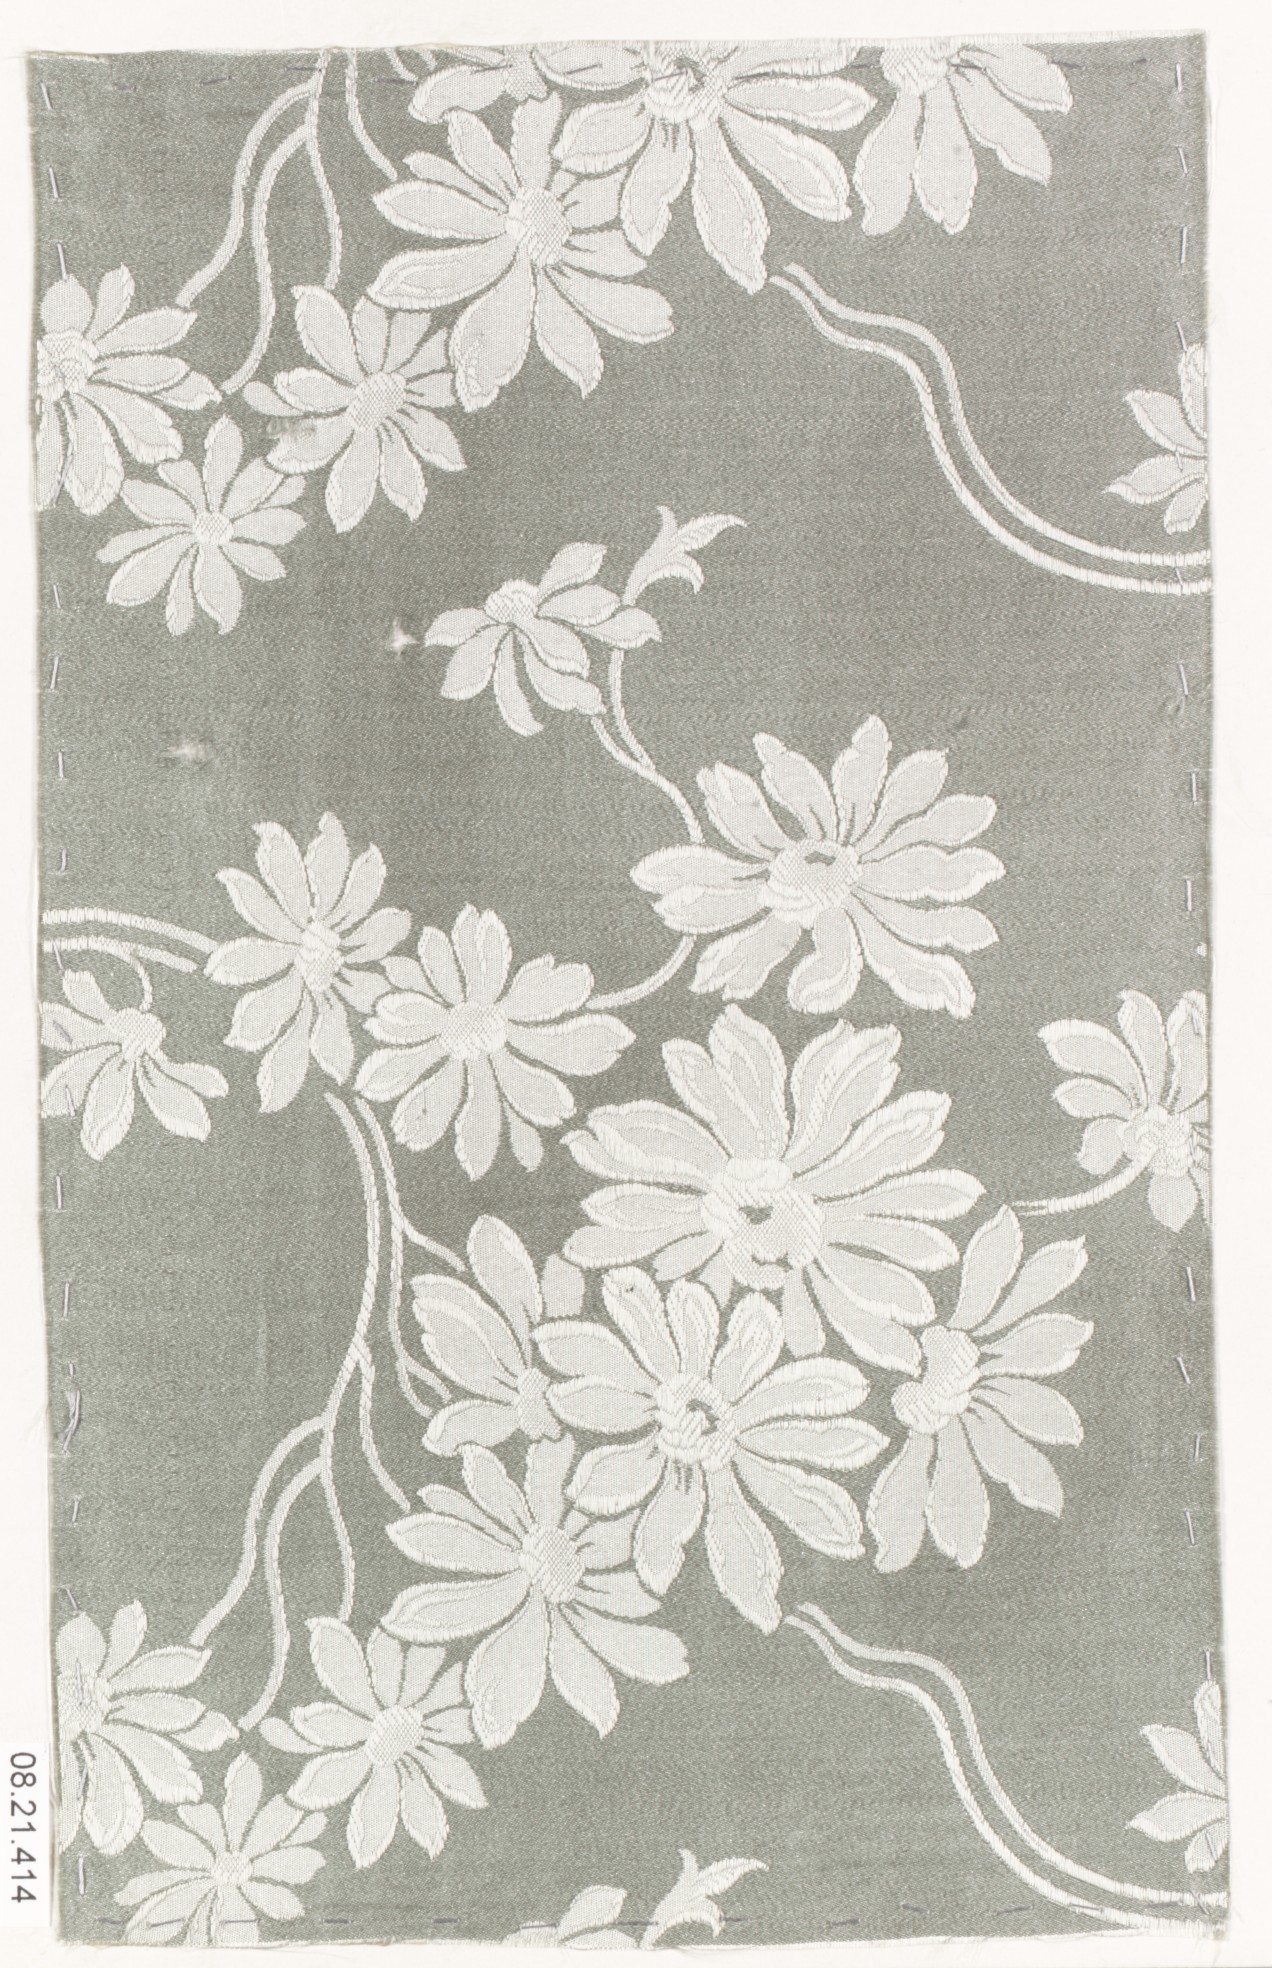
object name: textile sample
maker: Anonymous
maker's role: designer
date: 1900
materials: silk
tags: flowers